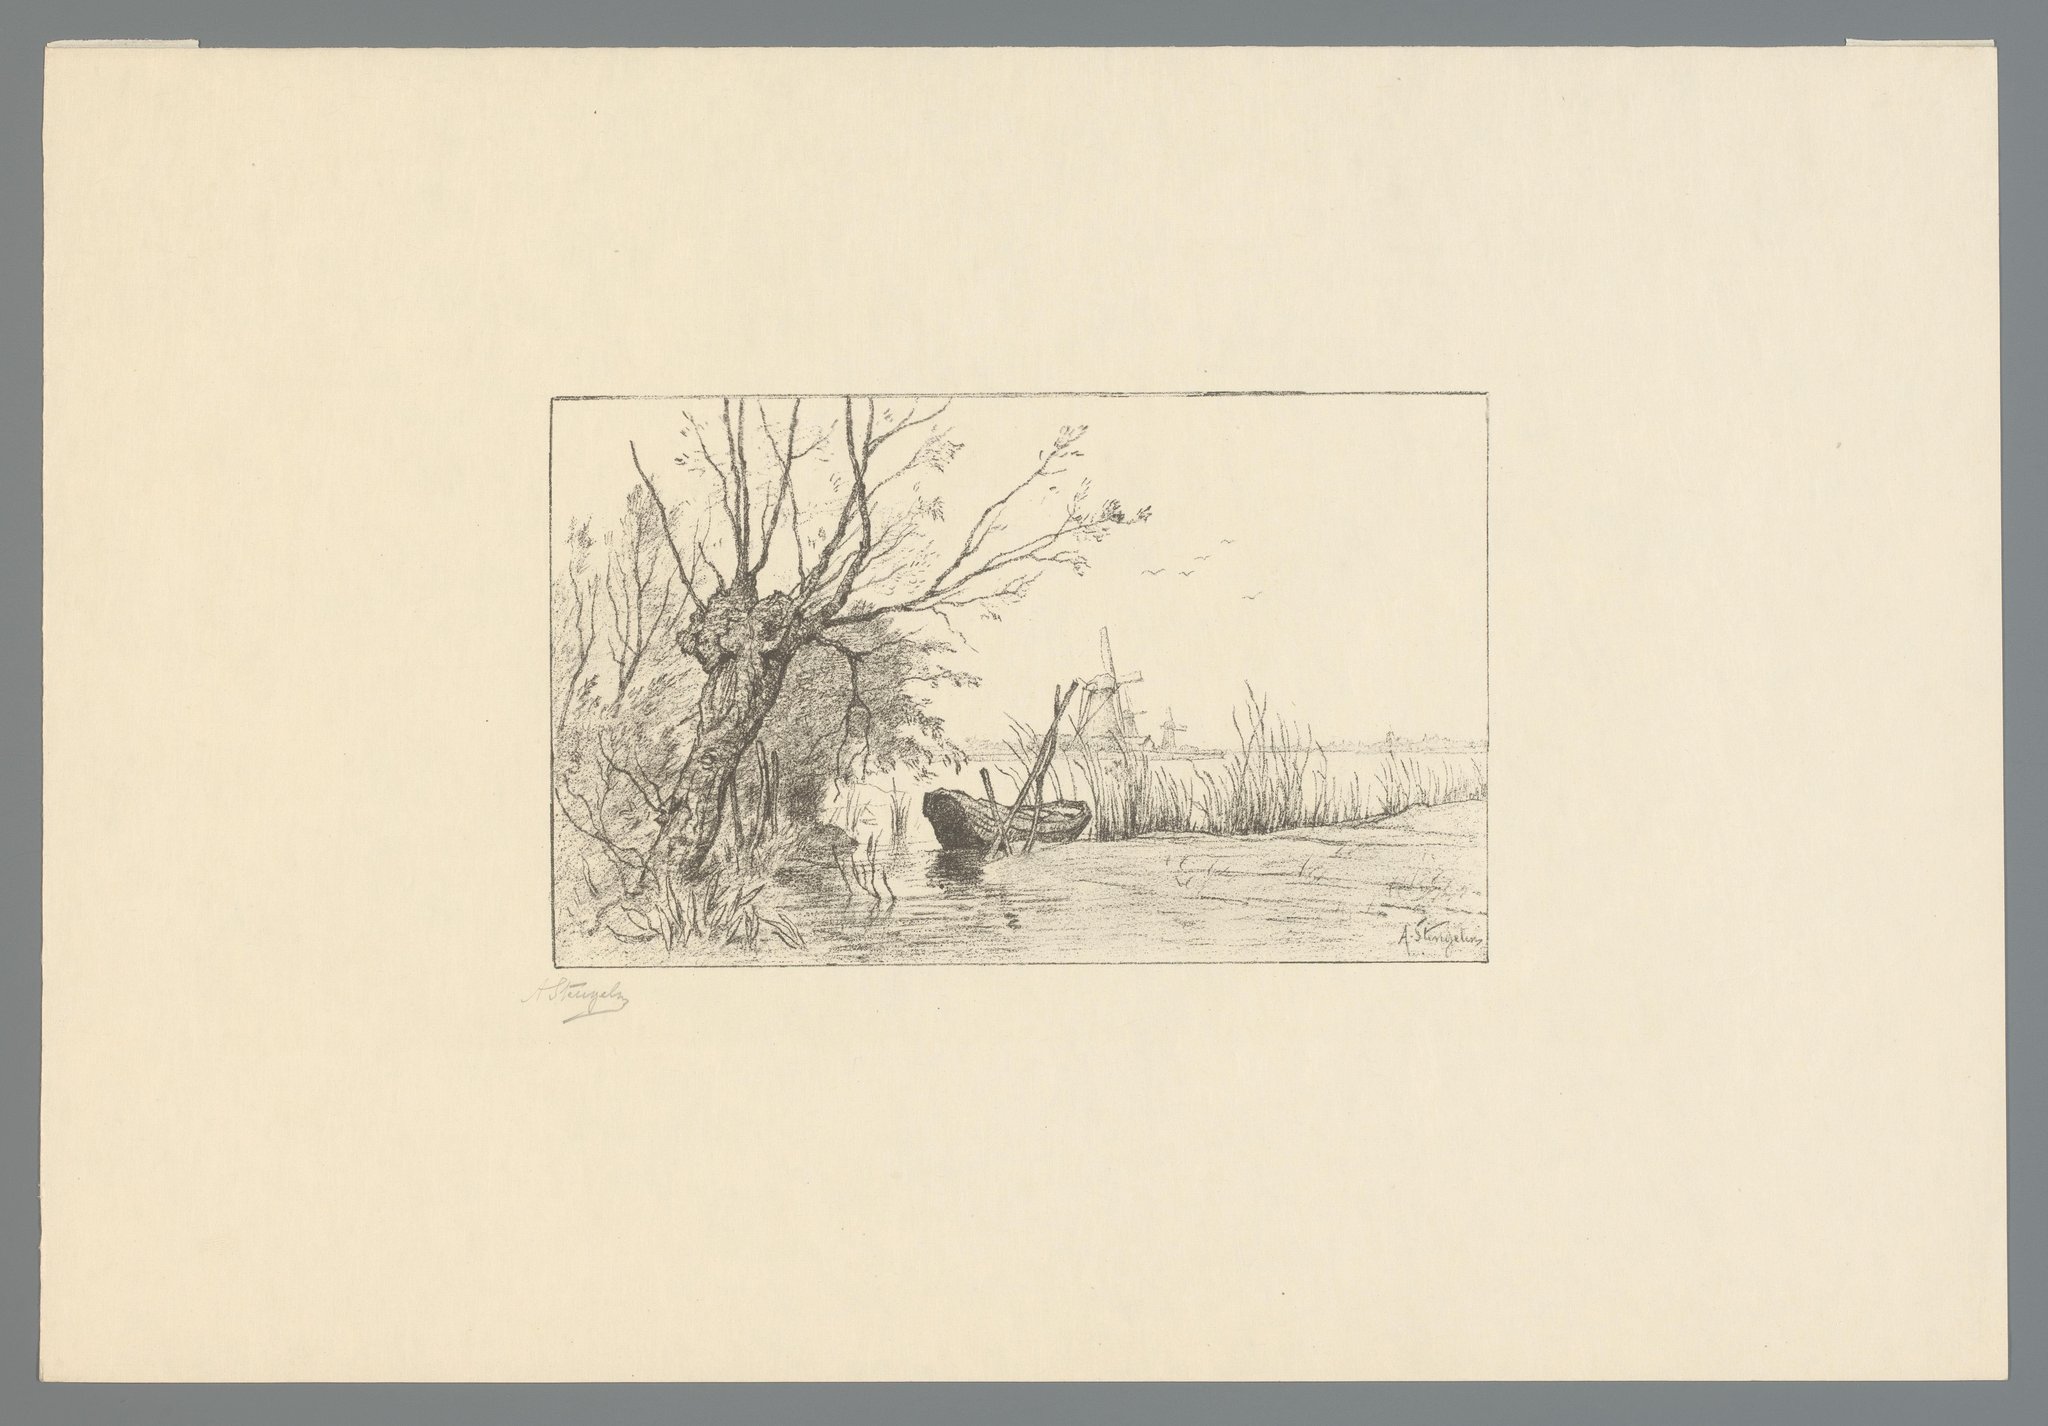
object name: print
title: Coin de la Rotte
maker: alphonse stengelin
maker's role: painter, print maker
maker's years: 1852-1938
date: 1876-1910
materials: paper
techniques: lithograph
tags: river, rowing-boat, canoe, etc., windmill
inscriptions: collector's mark: Lugt 2228